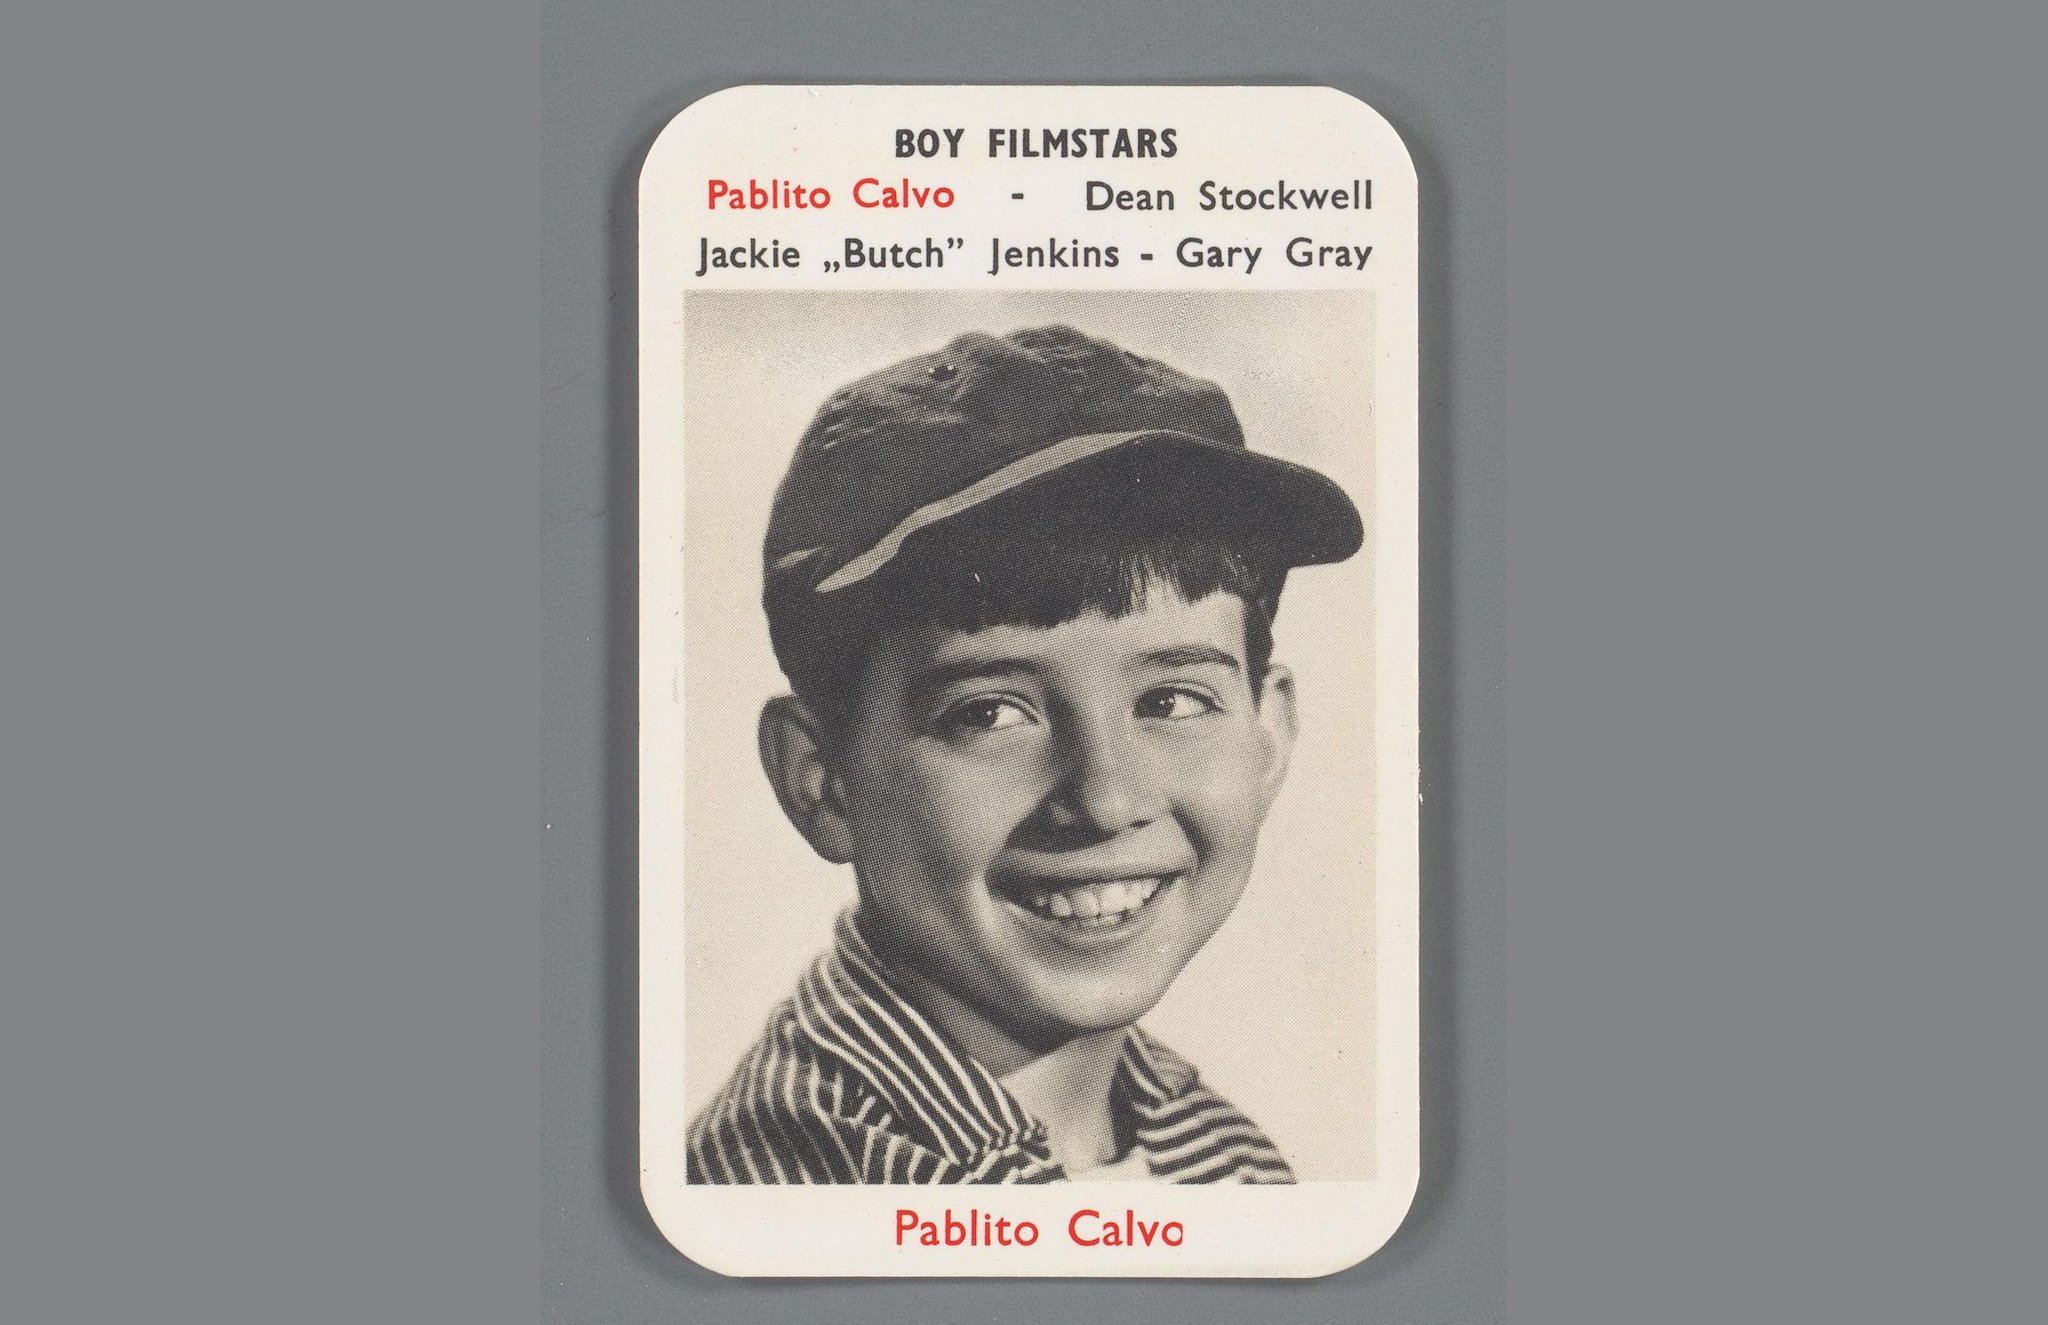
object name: playing card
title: Boy Filmstars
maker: Anonymous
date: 1960-1970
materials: paper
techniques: autotype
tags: portrait of actor, actress